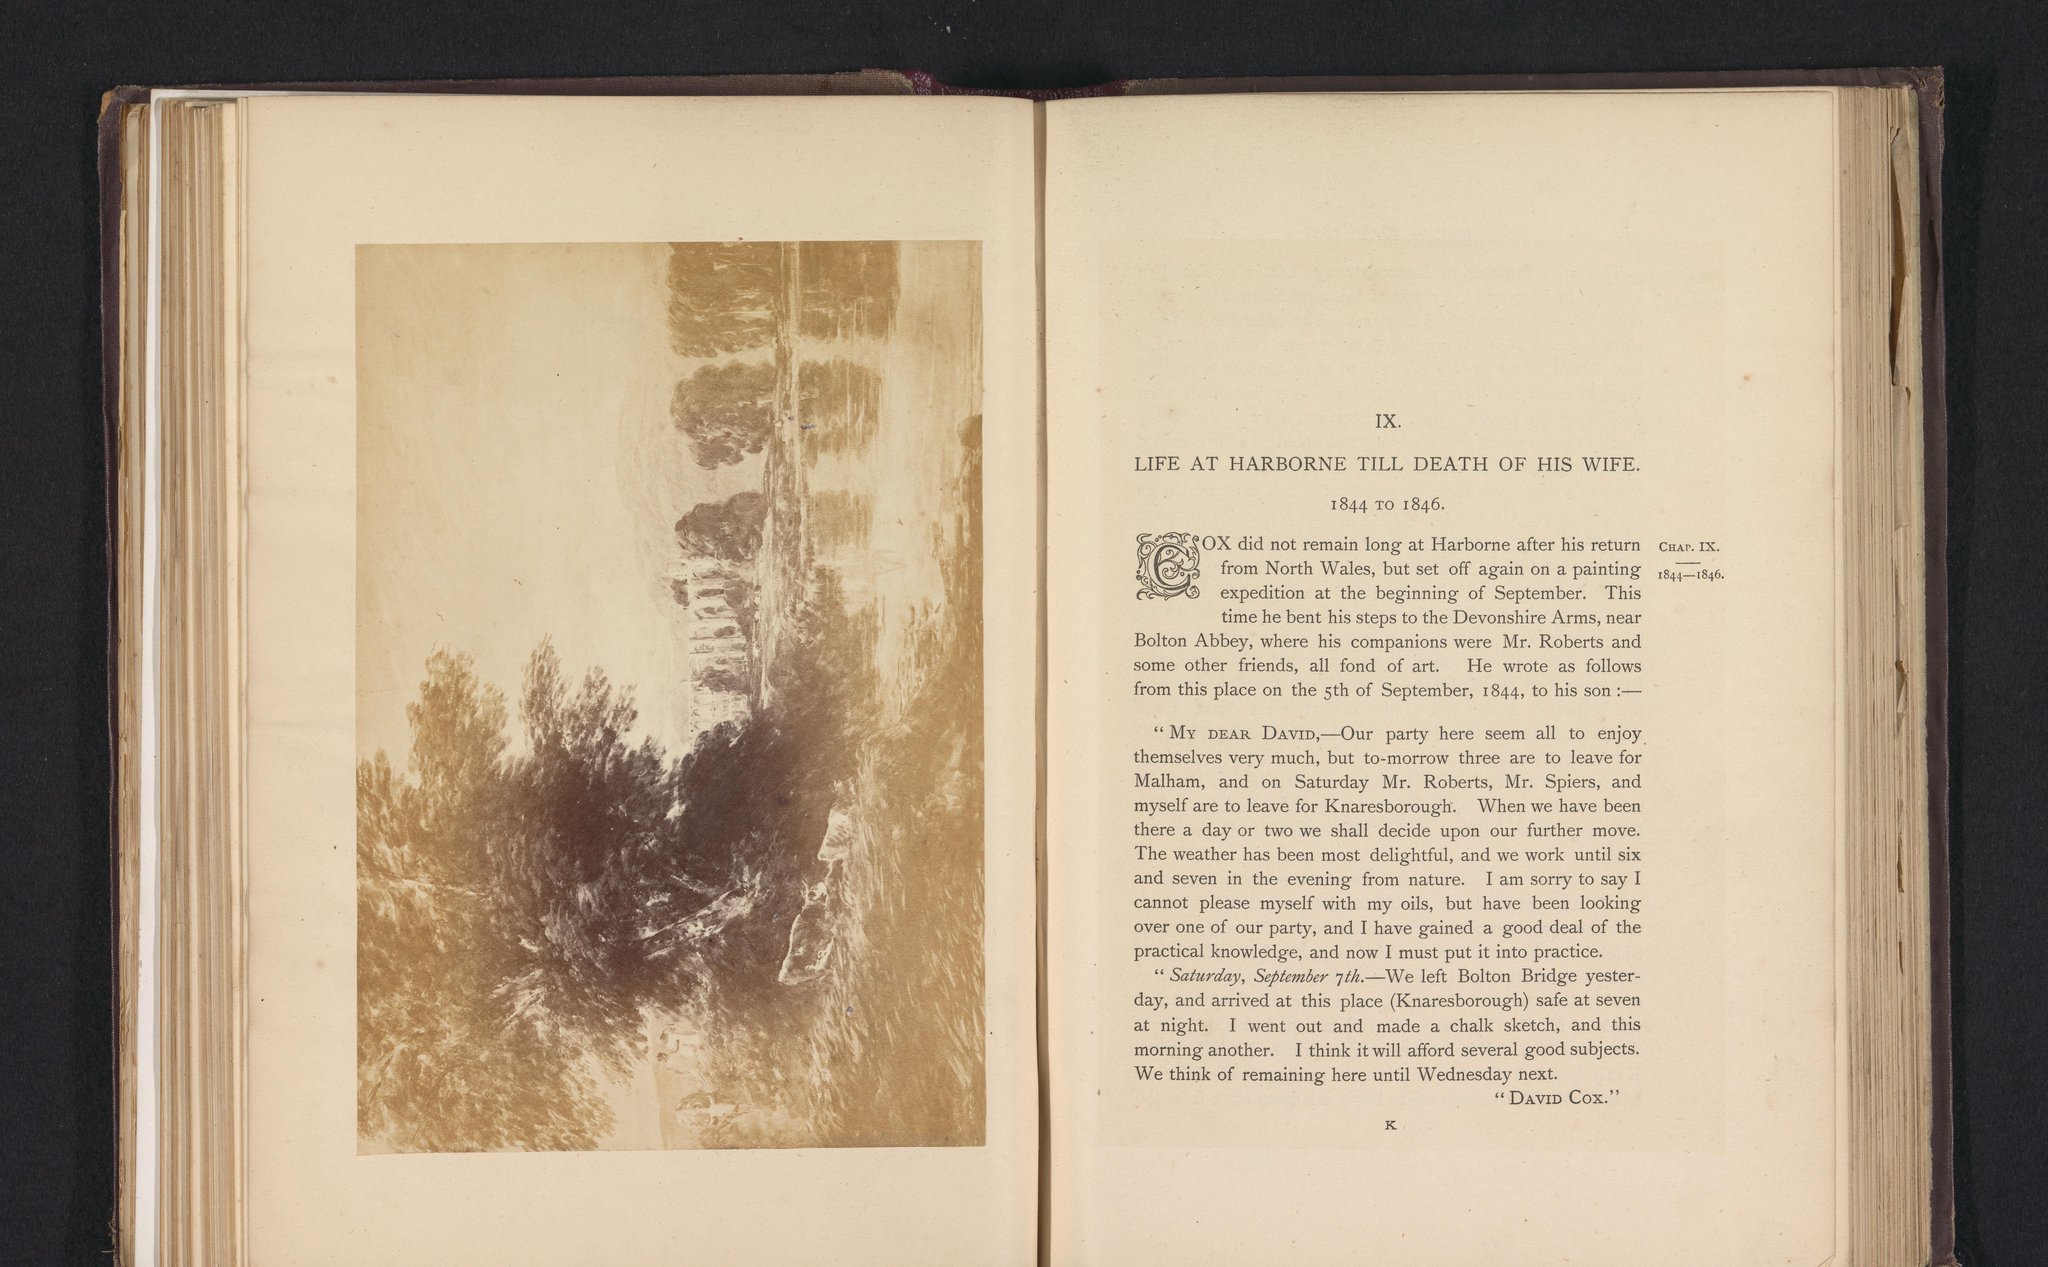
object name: page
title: Fotoreproductie van een tekening van Bolton Abbey met koeien op de voorgrond door David Cox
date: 1863-1873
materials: photographic support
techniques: albumen print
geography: bolton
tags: drawing, sketch, ruin of church, monastery, etc.